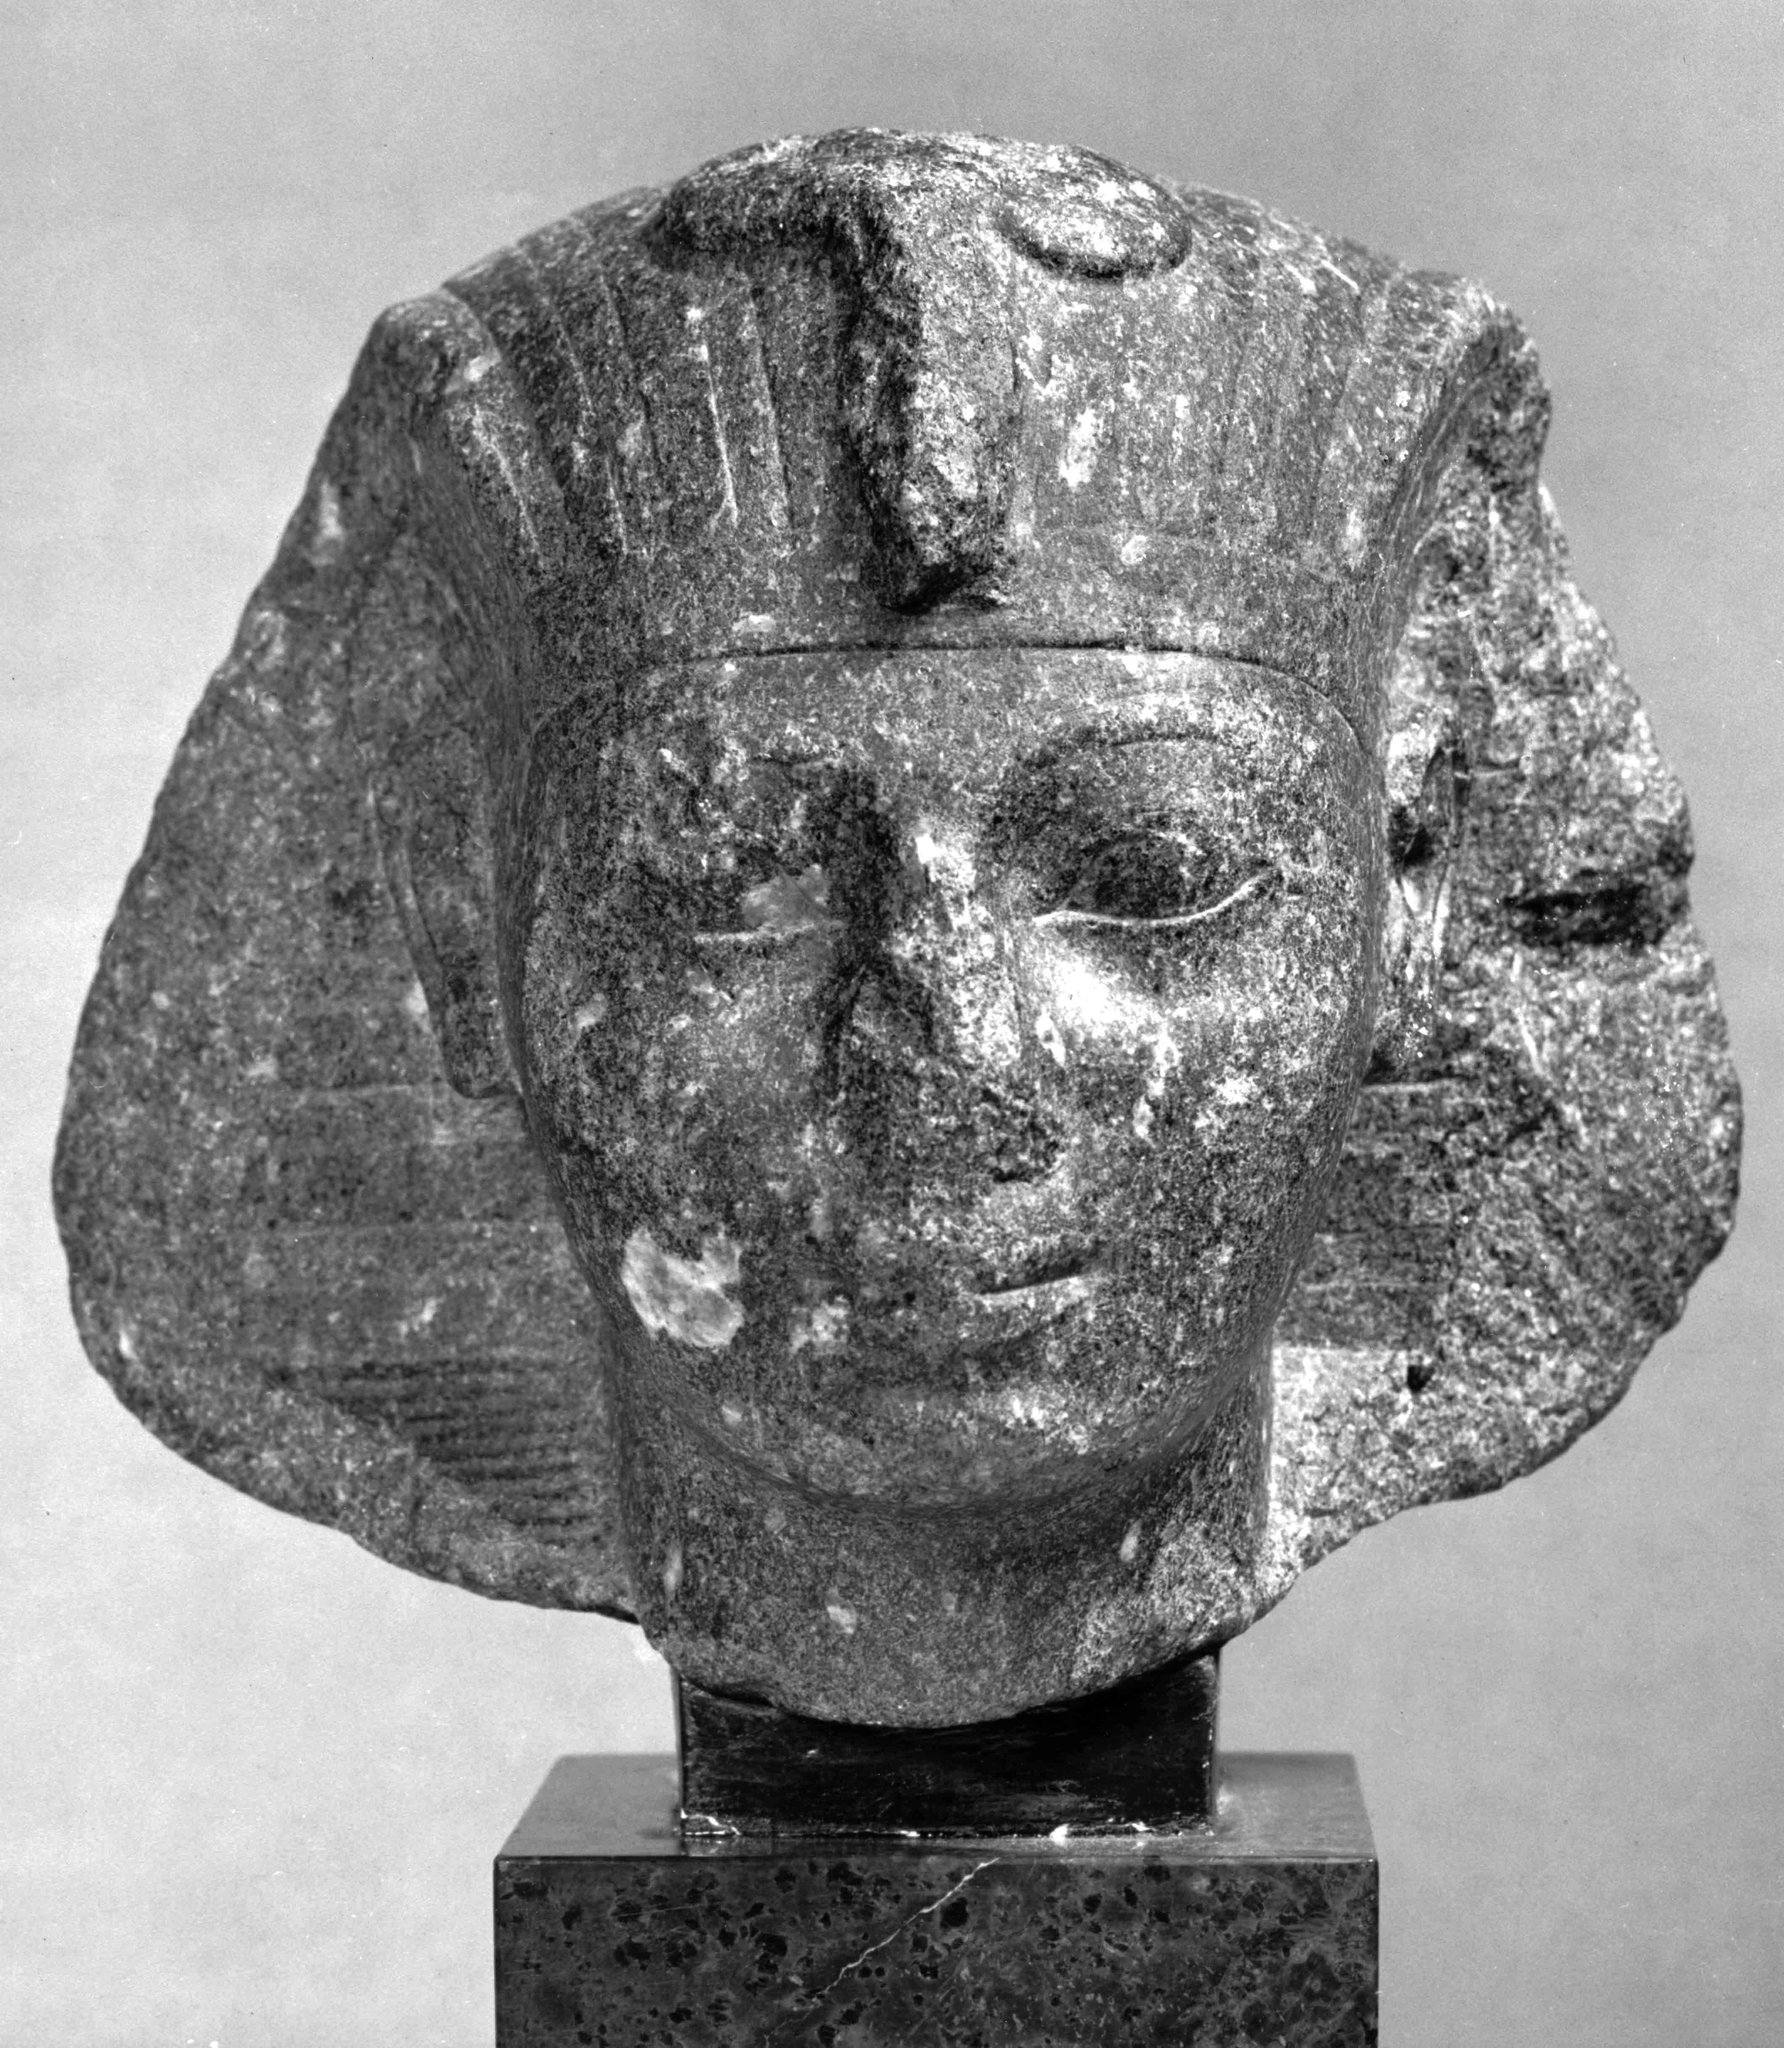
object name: head, thutmose iii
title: Head of Thutmose III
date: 1479-1425 BCE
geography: egypt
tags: heads,men